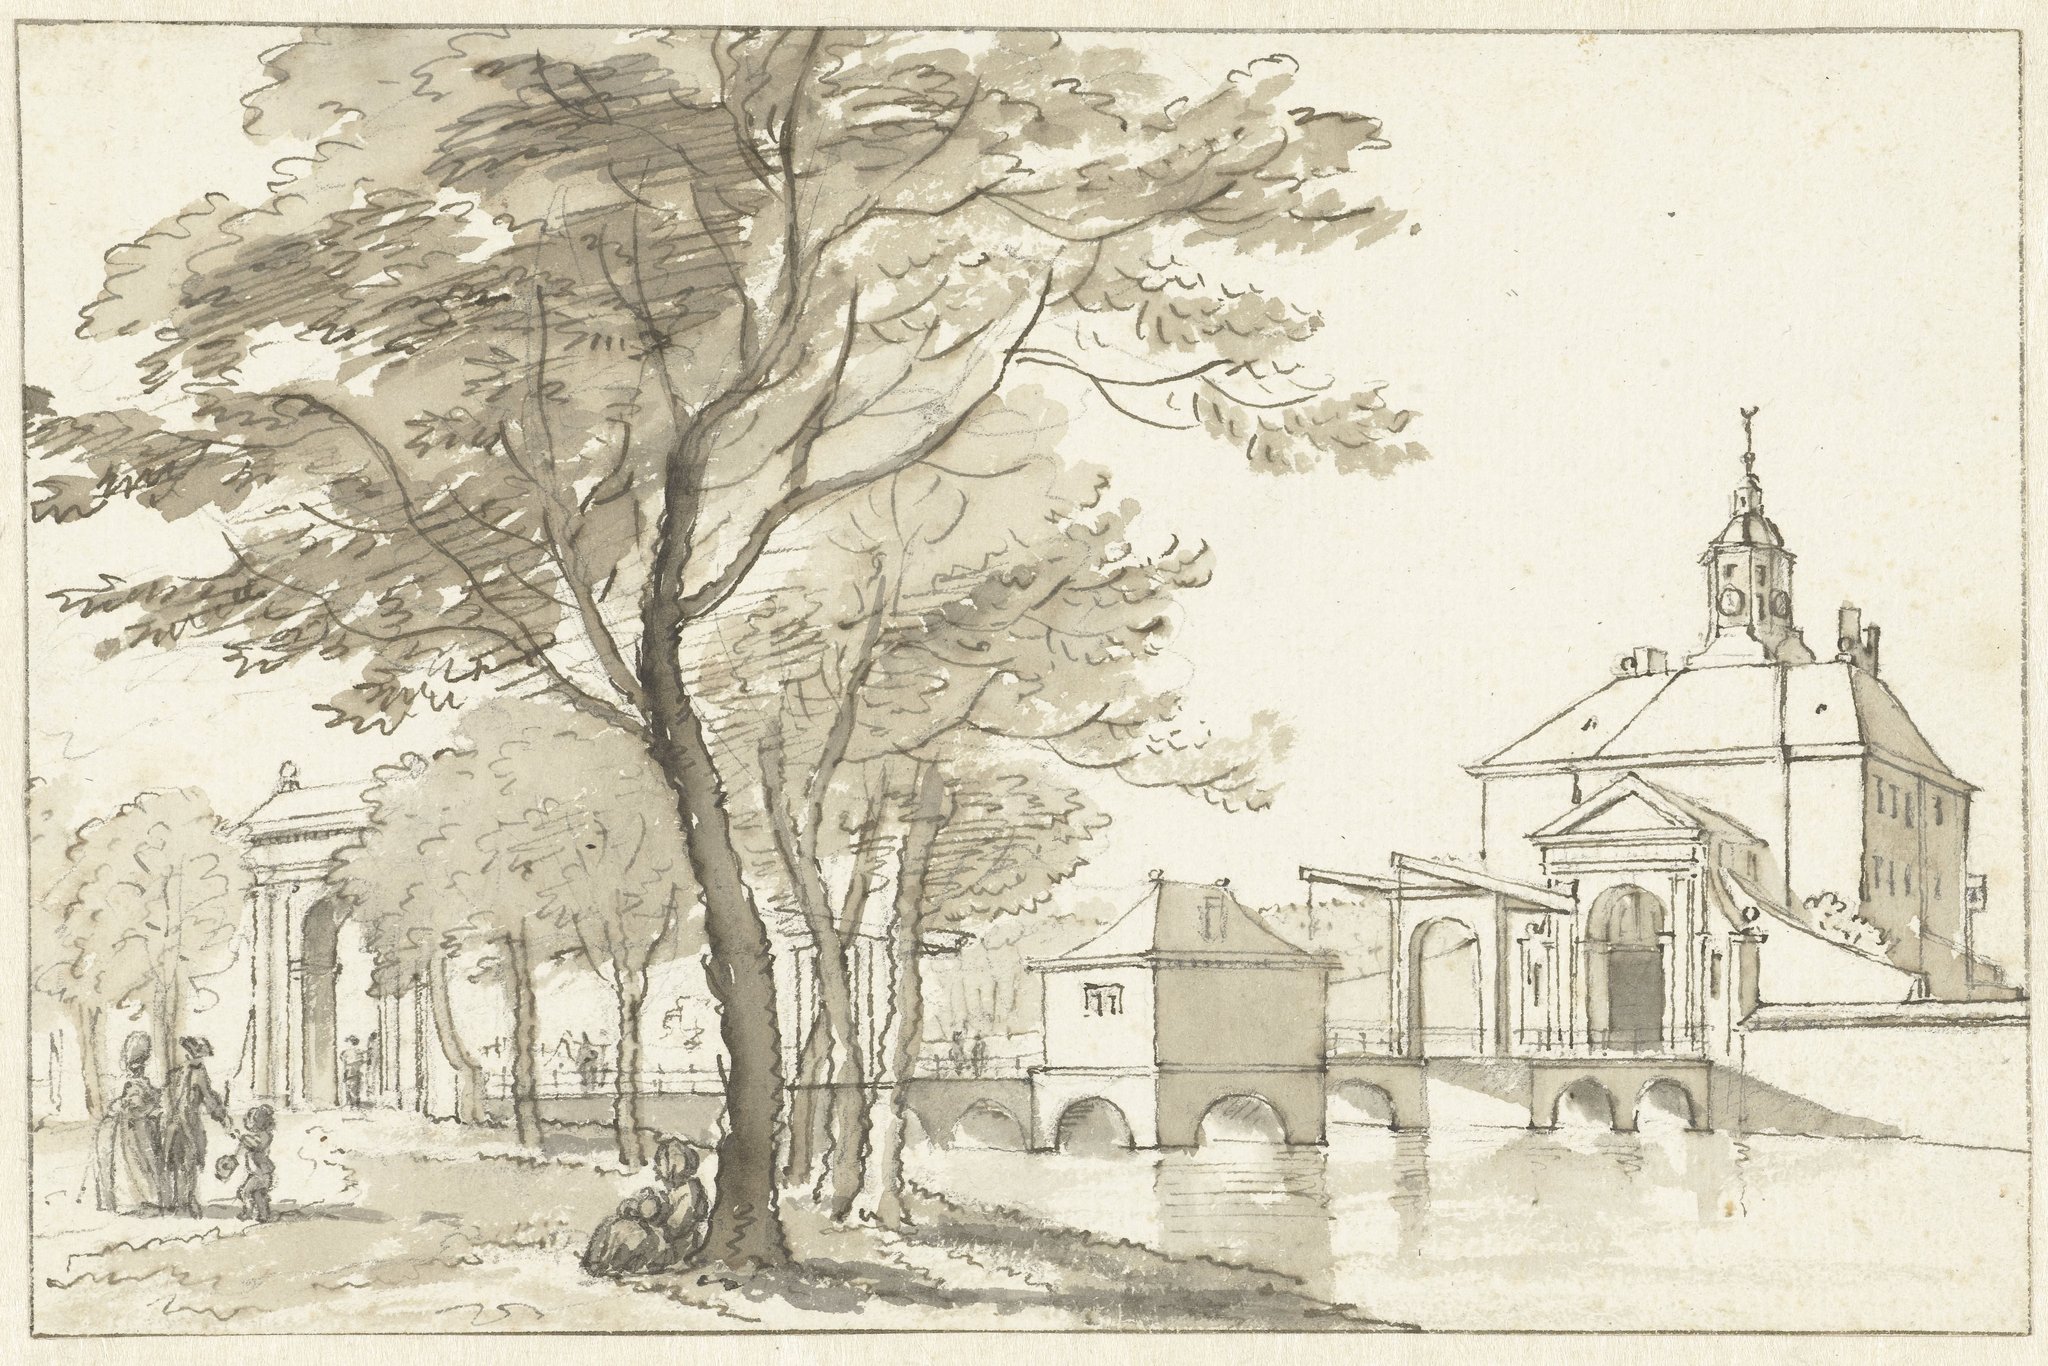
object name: drawing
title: De Muiderpoort, Amsterdam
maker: reinier vinkeles (i)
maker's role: draughtsman, print maker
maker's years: 1741-1816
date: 1768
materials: ink, paper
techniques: brush, pen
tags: city-walls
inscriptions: inscription: ‘Muyder Poort R Vinkeles delin 1768’